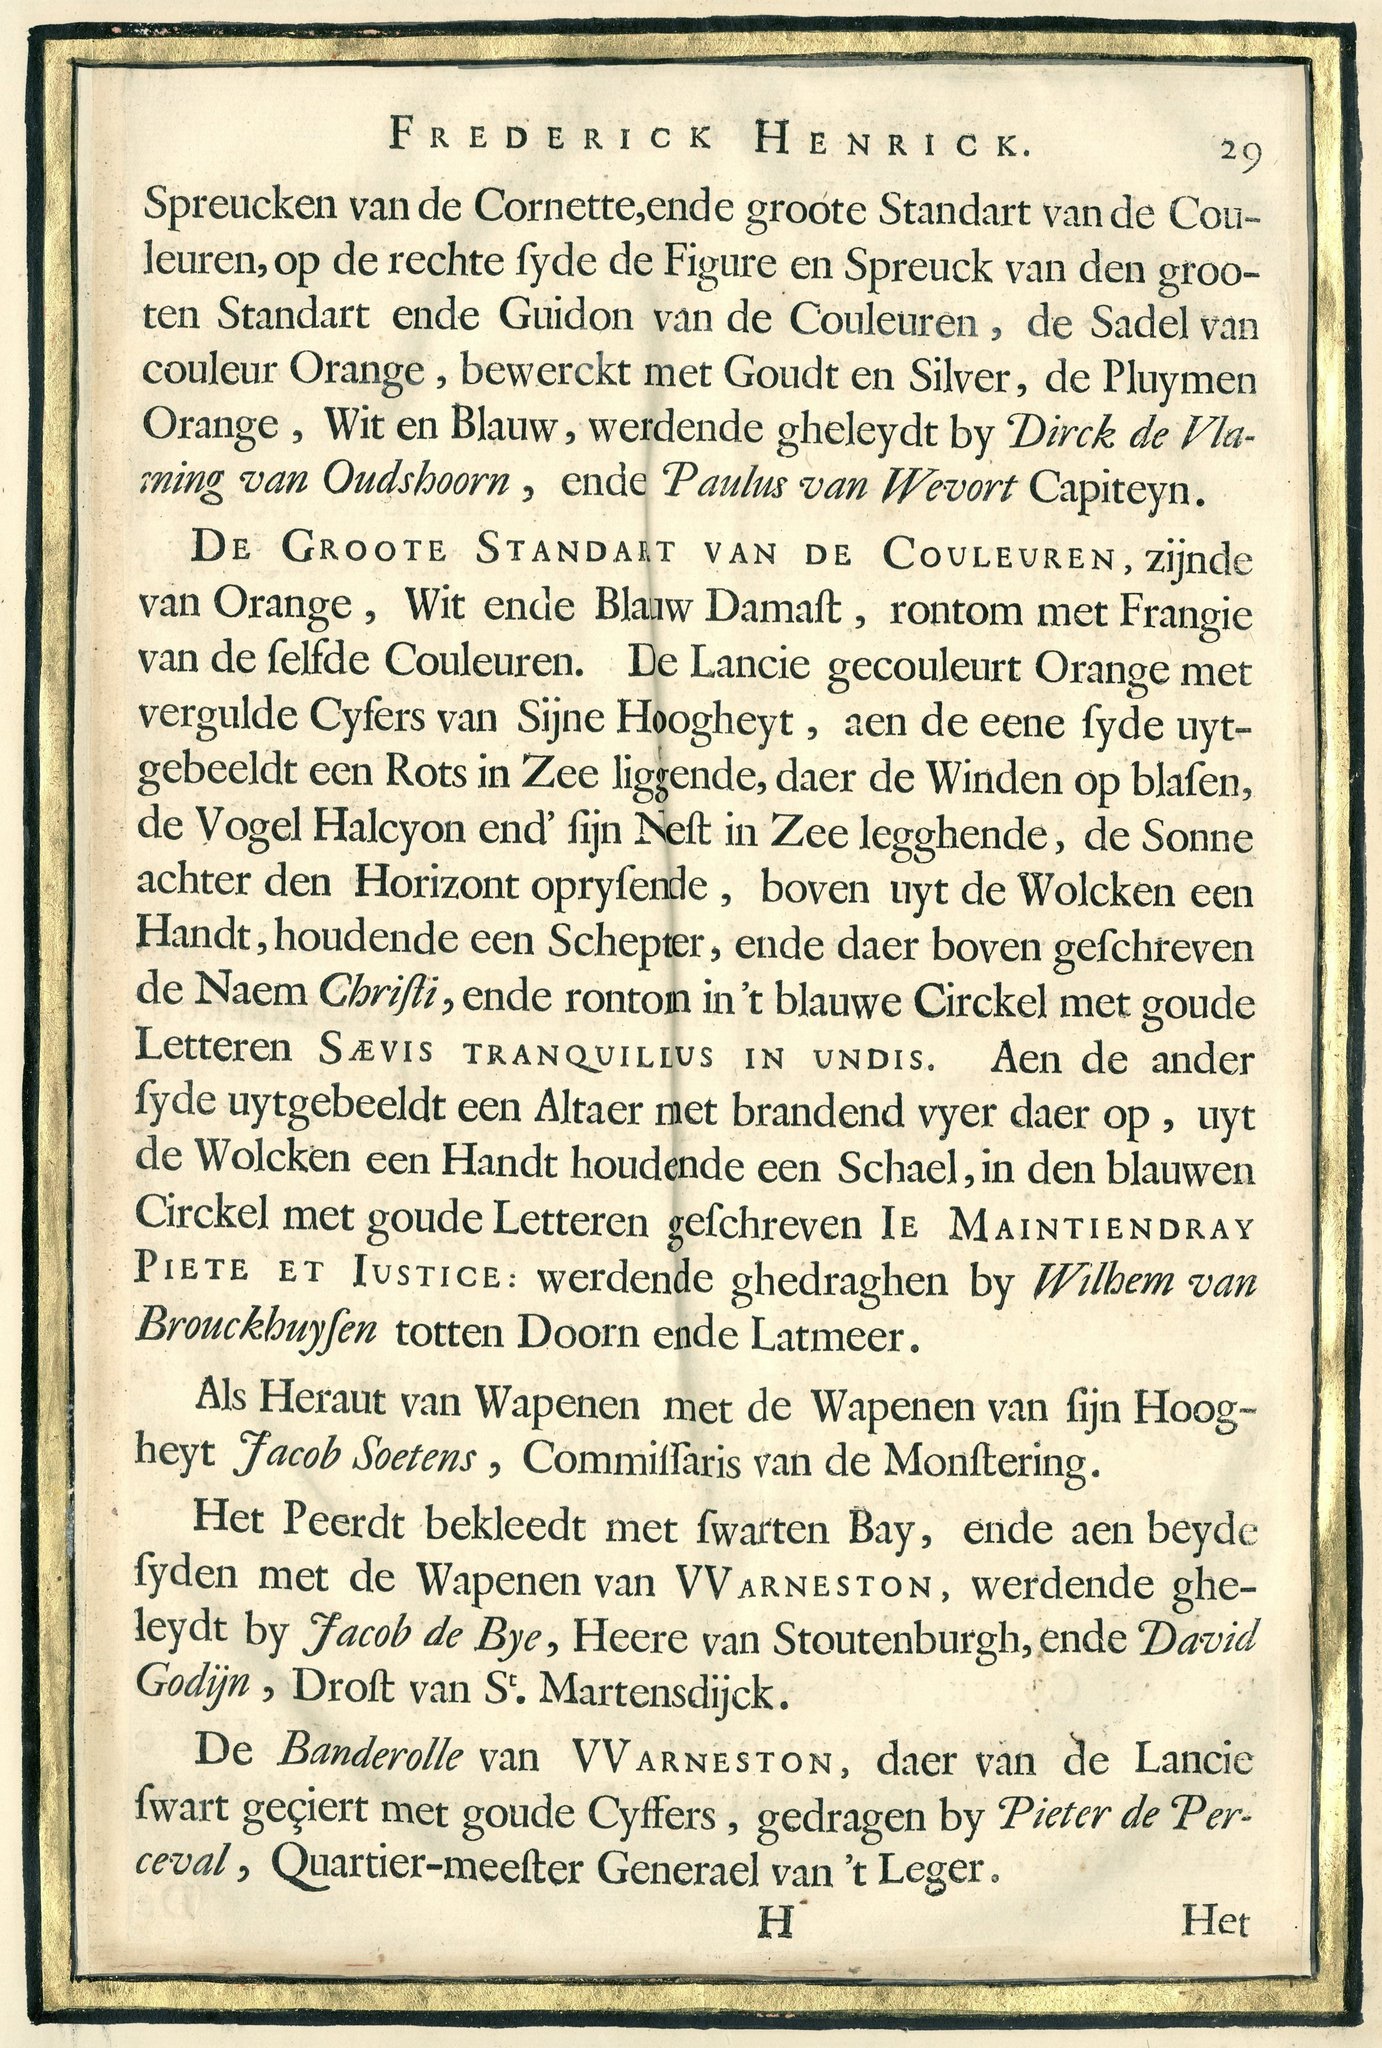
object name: book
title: De beschrijving van de begrafenis van Frederik Hendrik, p. 29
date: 1651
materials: paint, paper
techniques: letterpress printing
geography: amsterdam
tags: delft, frederick henry (prince of orange)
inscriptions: date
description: Pagina 29 van de beschrijving van de begrafenis van Frederik Hendrik. Blad uitgeknipt, versierd met goud en ingeplakt in de luxe editie uit ca. 1755 van het boek 'Begraeffenisse van syne hoogheyt Frederick Henrick' van Pieter Post, uitgegeven te Amsterdam in 1651.